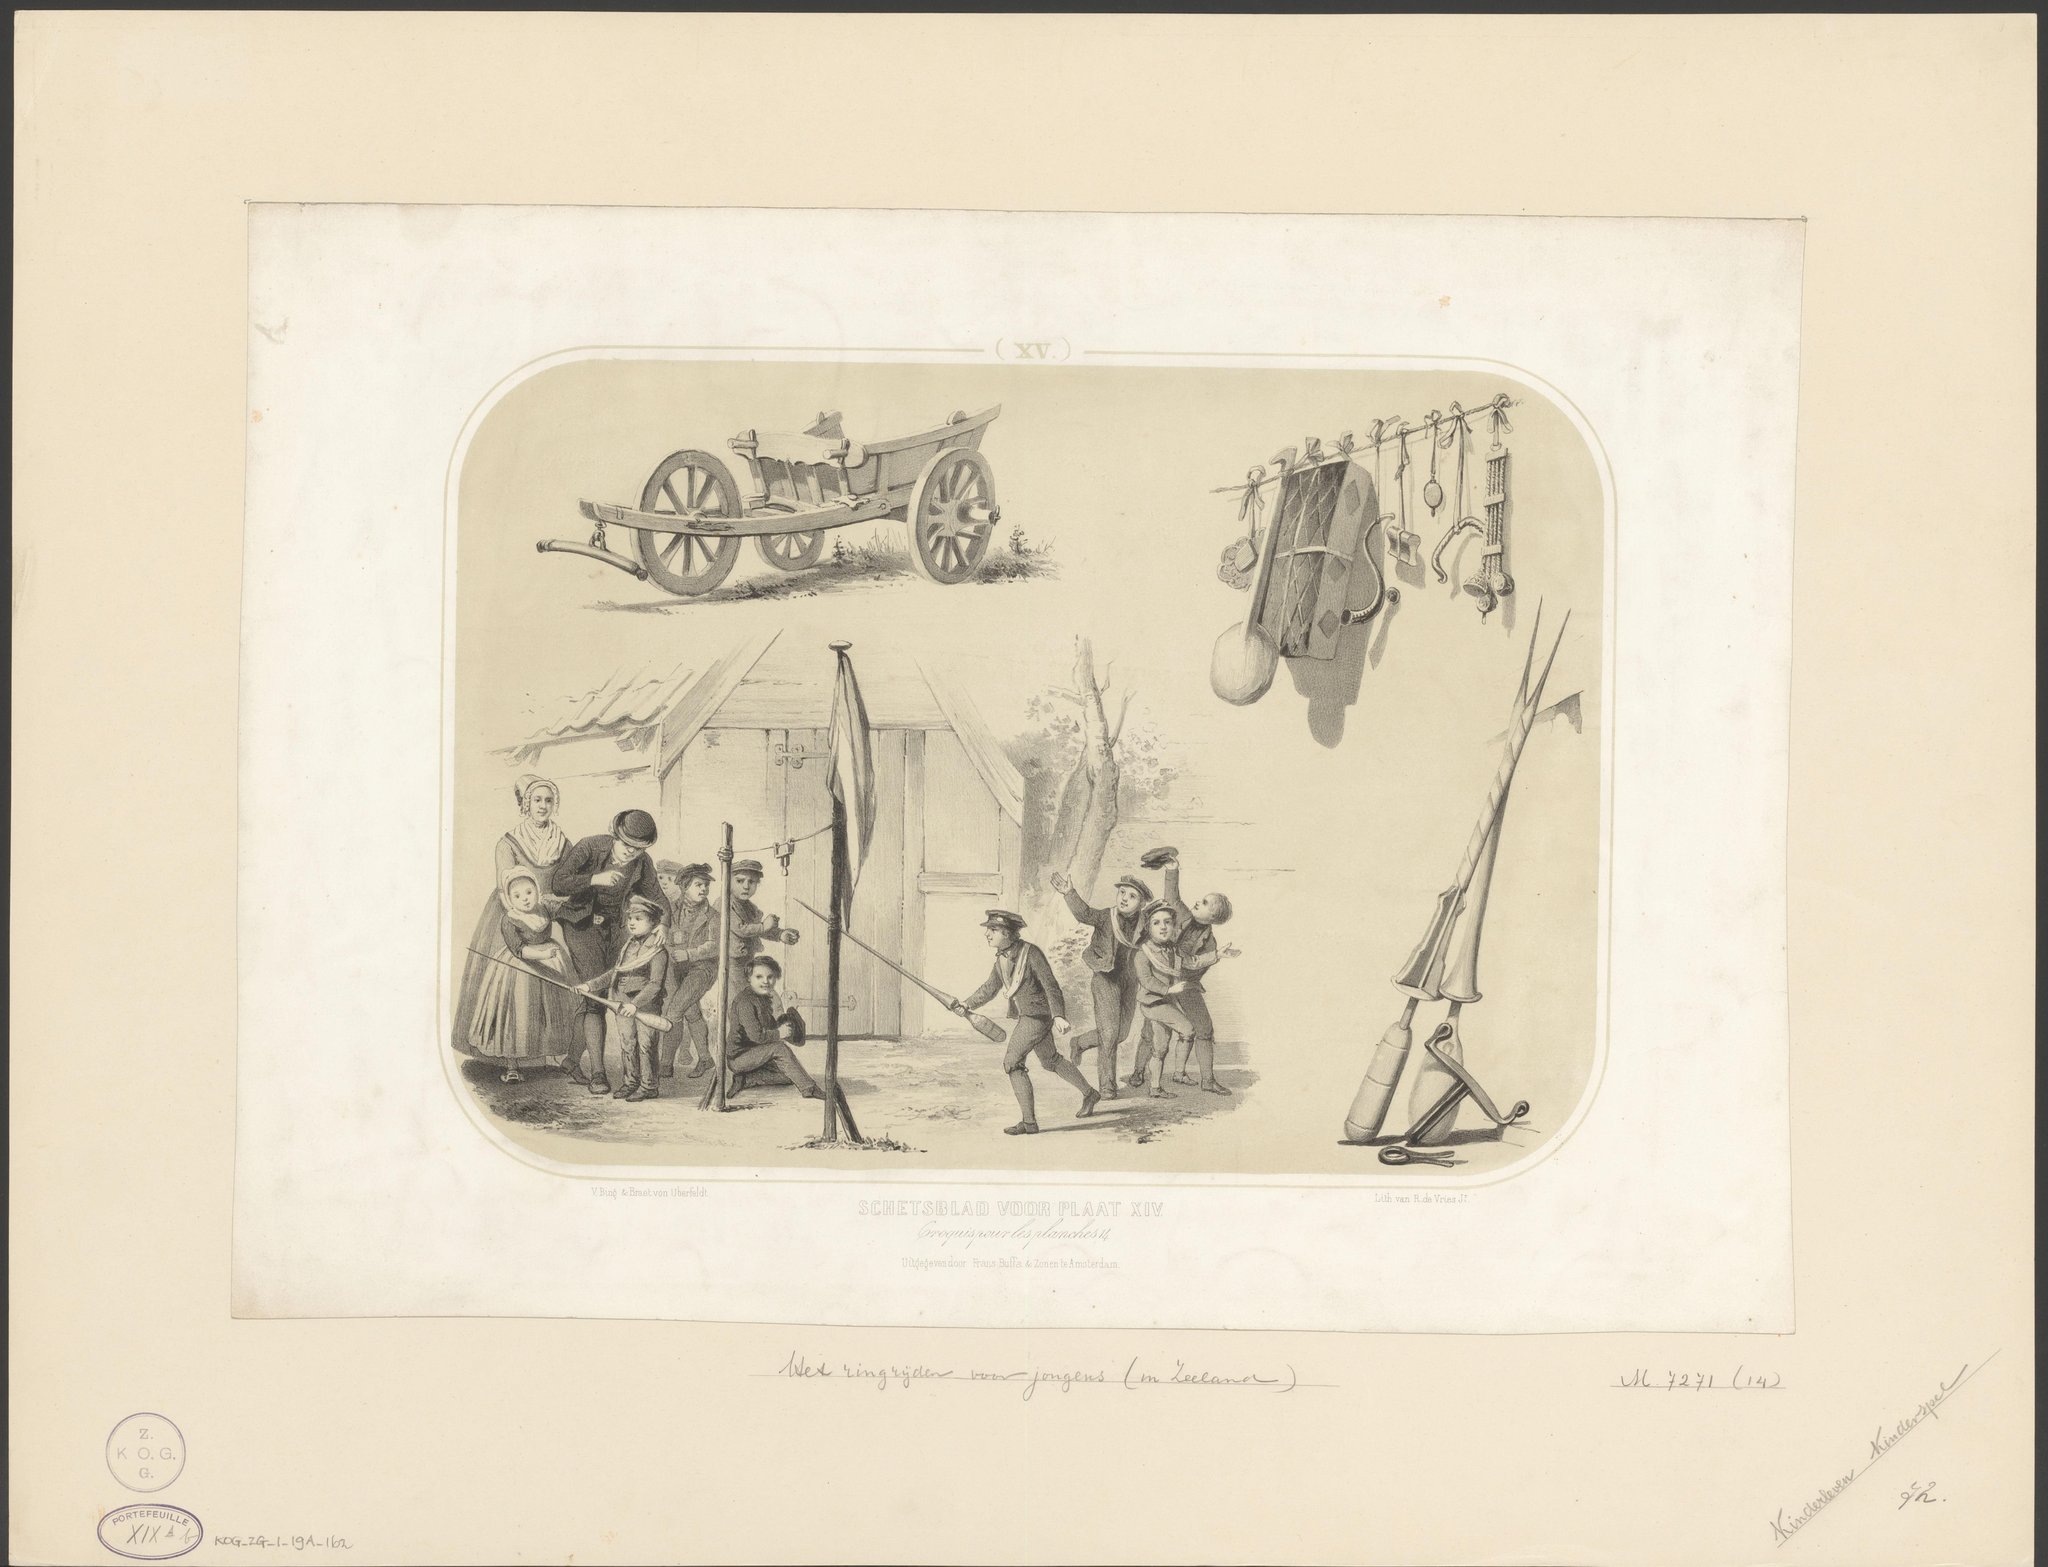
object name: print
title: Ringsteken en attributen voor ringsteken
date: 1884-1951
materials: paper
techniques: tone lithography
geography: amsterdam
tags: children's games and plays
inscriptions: collector's mark: Lugt 1641, stamp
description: Bovenaan genummerd: XV. Onderwerpsrubrieken binnen de Atlas Zeden en Gewoonten: Zeden en Gewoonten in Engeren Zin, Des menschen beging, midden en einde, Kinderleven – Kinderspel en Kinderprenten.